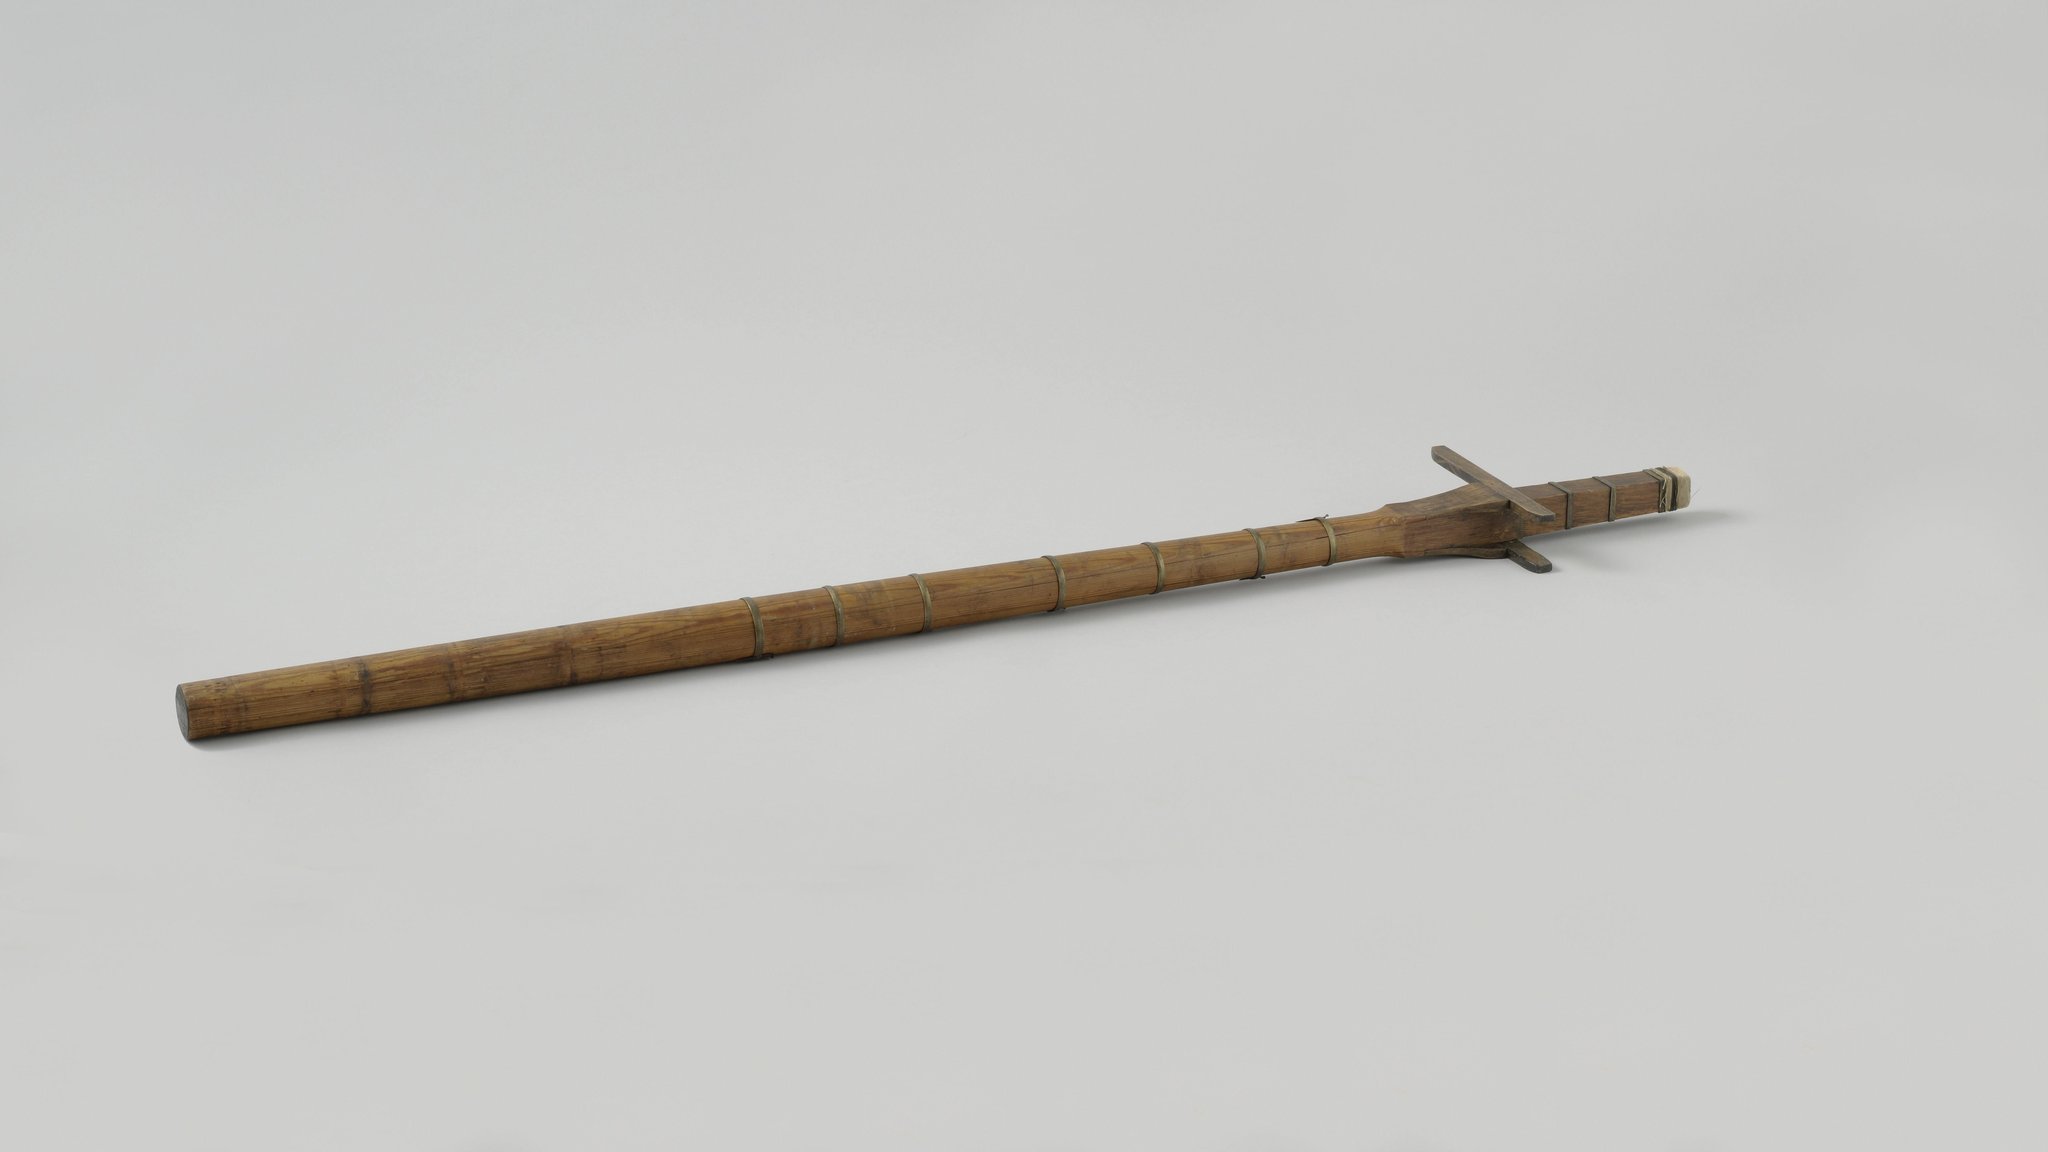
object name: scale model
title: Model of a Made Mast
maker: Anonymous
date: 1400-1950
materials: brass, textile, wood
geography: netherlands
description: Model van een ronde gekuipte mast met nommers en langszalingen. De mast bestaat uit een solide koning en twee schalen, bijeengehouden door koperen hoepels. De hoepels worden aangespannen met wiggen. Boven de zalingen is de mast vierkant met eveneens koperen hoepels. De top is met textiel bekleed.